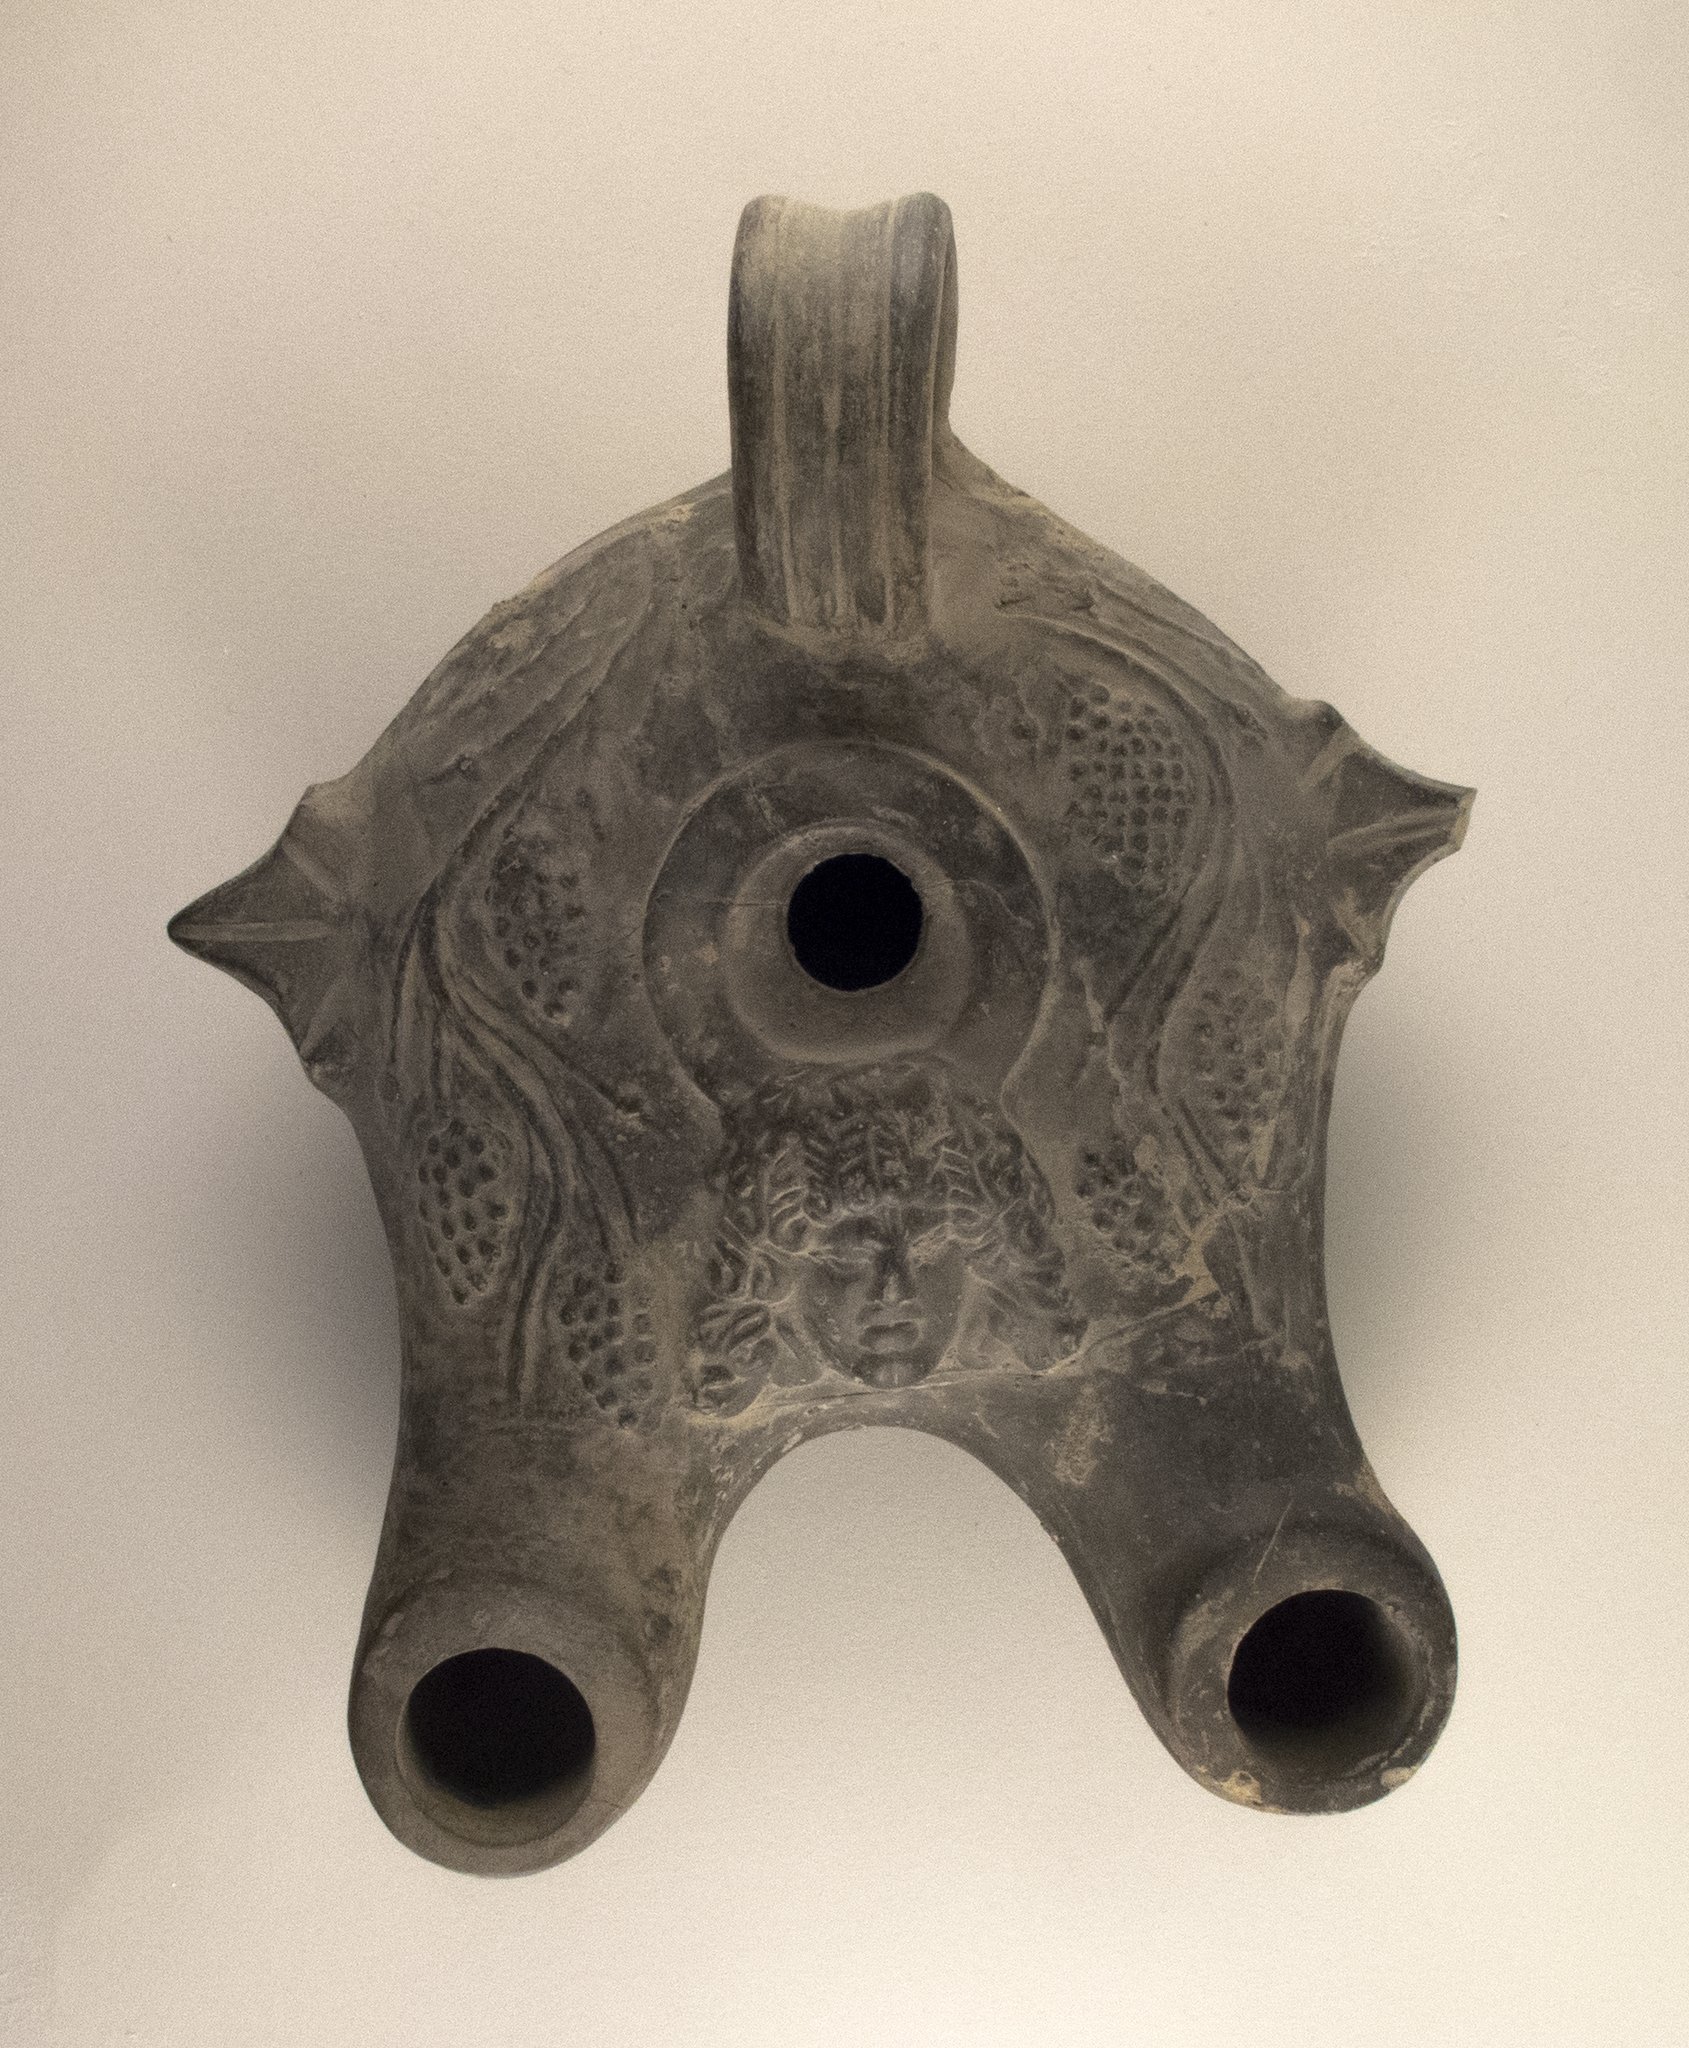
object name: lamp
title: Terracotta lamp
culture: roman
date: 670 BCE-330 CE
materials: terracotta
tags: heads